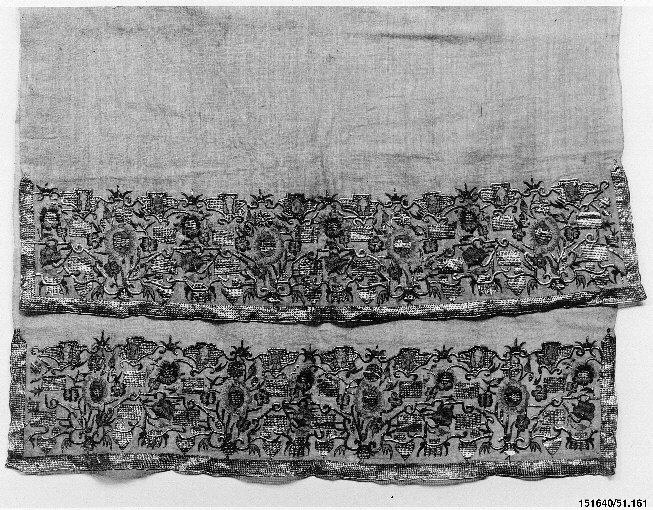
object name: towel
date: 1734-1766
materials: cotton, metal thread, silk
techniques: embroidery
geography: turkey